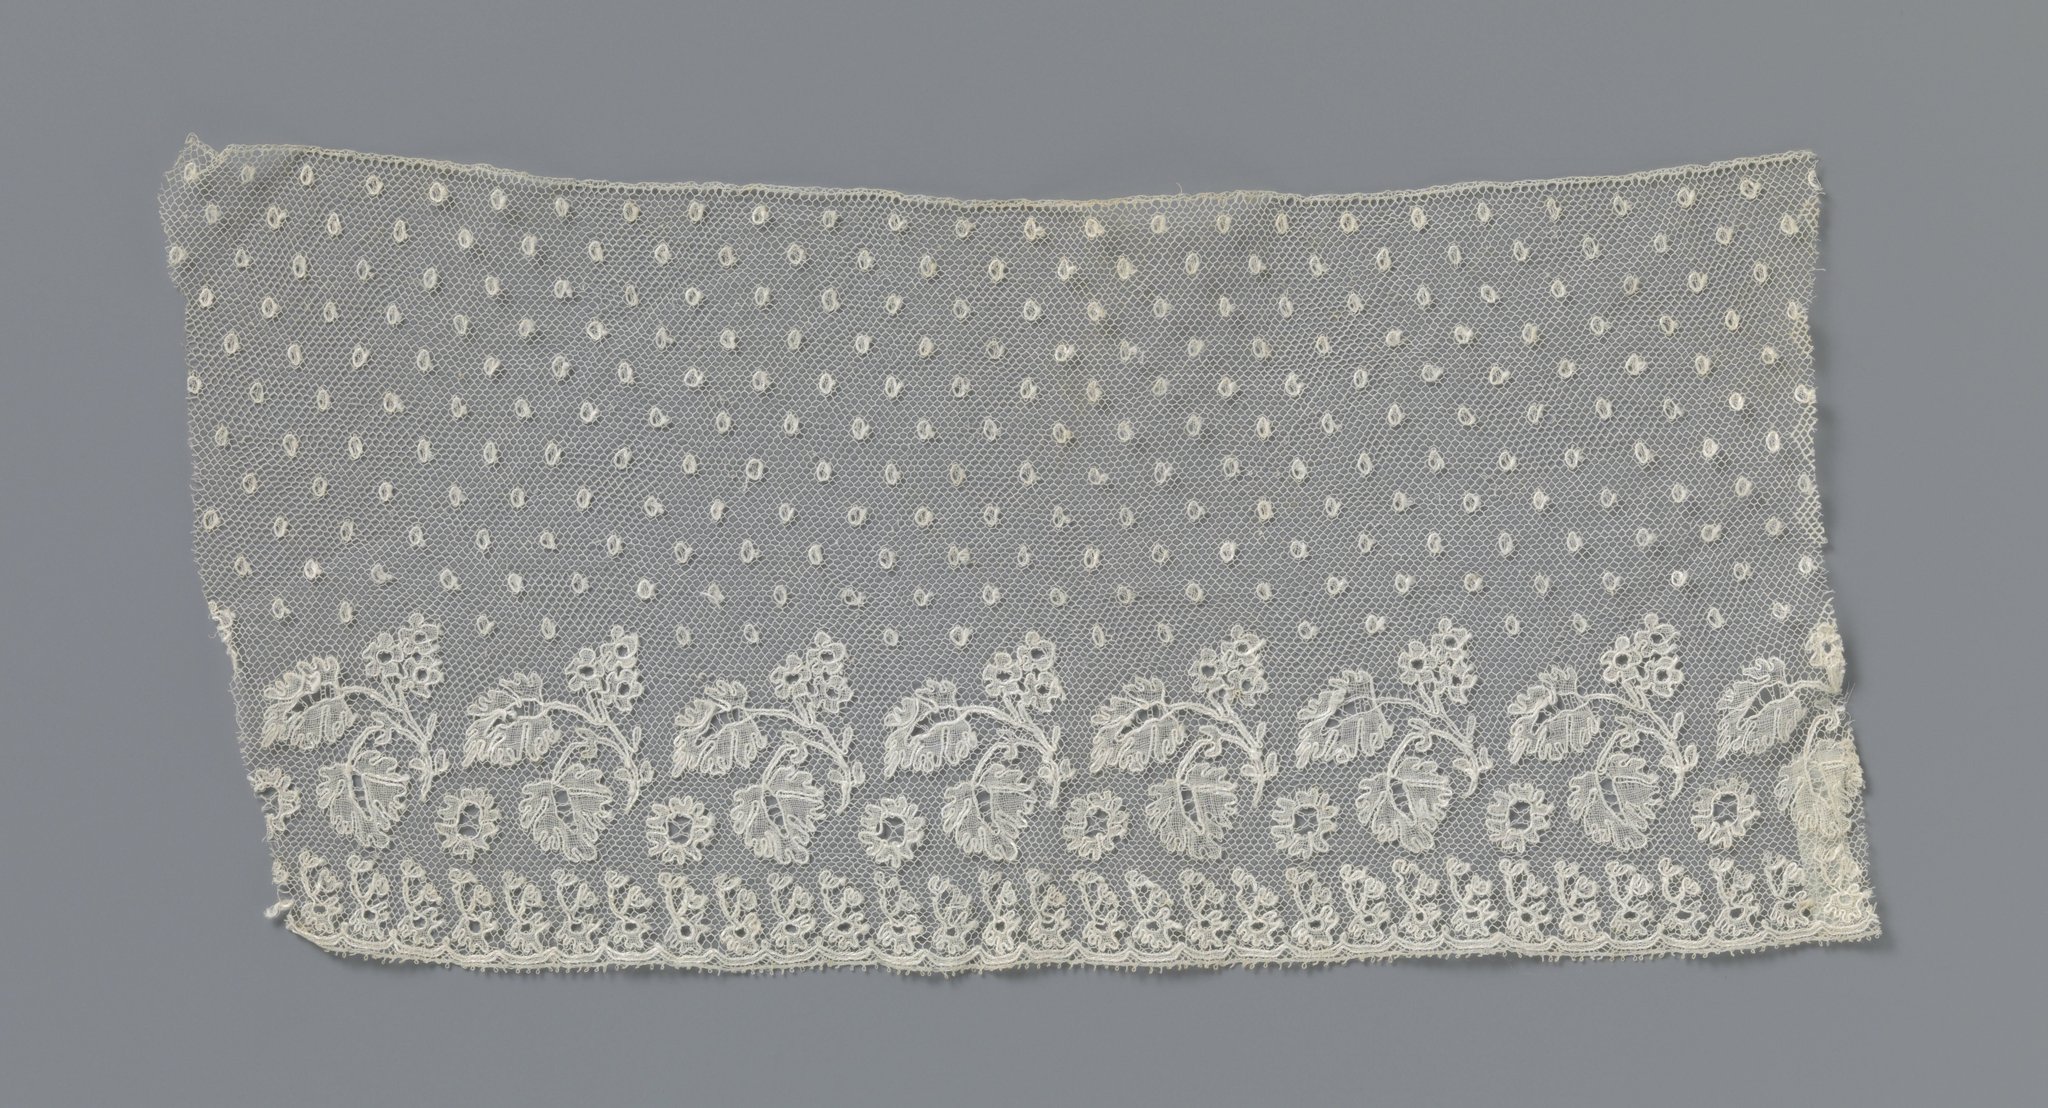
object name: strip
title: Strook kloskant met bloesemtakken onder brede baan moesjes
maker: Anonymous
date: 1840-1849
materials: linen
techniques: lace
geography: belgium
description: Strook naturelkleurige kloskant: Rijselse kant. Onder een brede baan met een strooipatroon van ovale moesjes bestaat het zich herhalende patroon uit een bloesemtak, met daaraan drie kleine rozetbloempjes en naar beneden buigende bladeren. Tussen de opeenvolgende takken staat een losse rozetbloem. Langs de onderzijde van de strook staat een rij met dicht op elkaar geplaatste hangende takjes met steeds één rozetbloempje onderaan. De motieven zijn met elkaar verbonden door een fijne traliegrond, een tulegrond. De motieven zijn gemaakt in linnenslag met uitsparingen en dikkere en glimmende contourdraden. Ook om de moesjes loopt een contourdraad. Er is spaarzaam een siergrond toegepast in de nerven van de bladeren, in de losse rozetbloemen en om de bloesemhartjes. Boven en onderzijde zijn recht afgewerkt, waarbij de onderzijde is voorzien van picots.